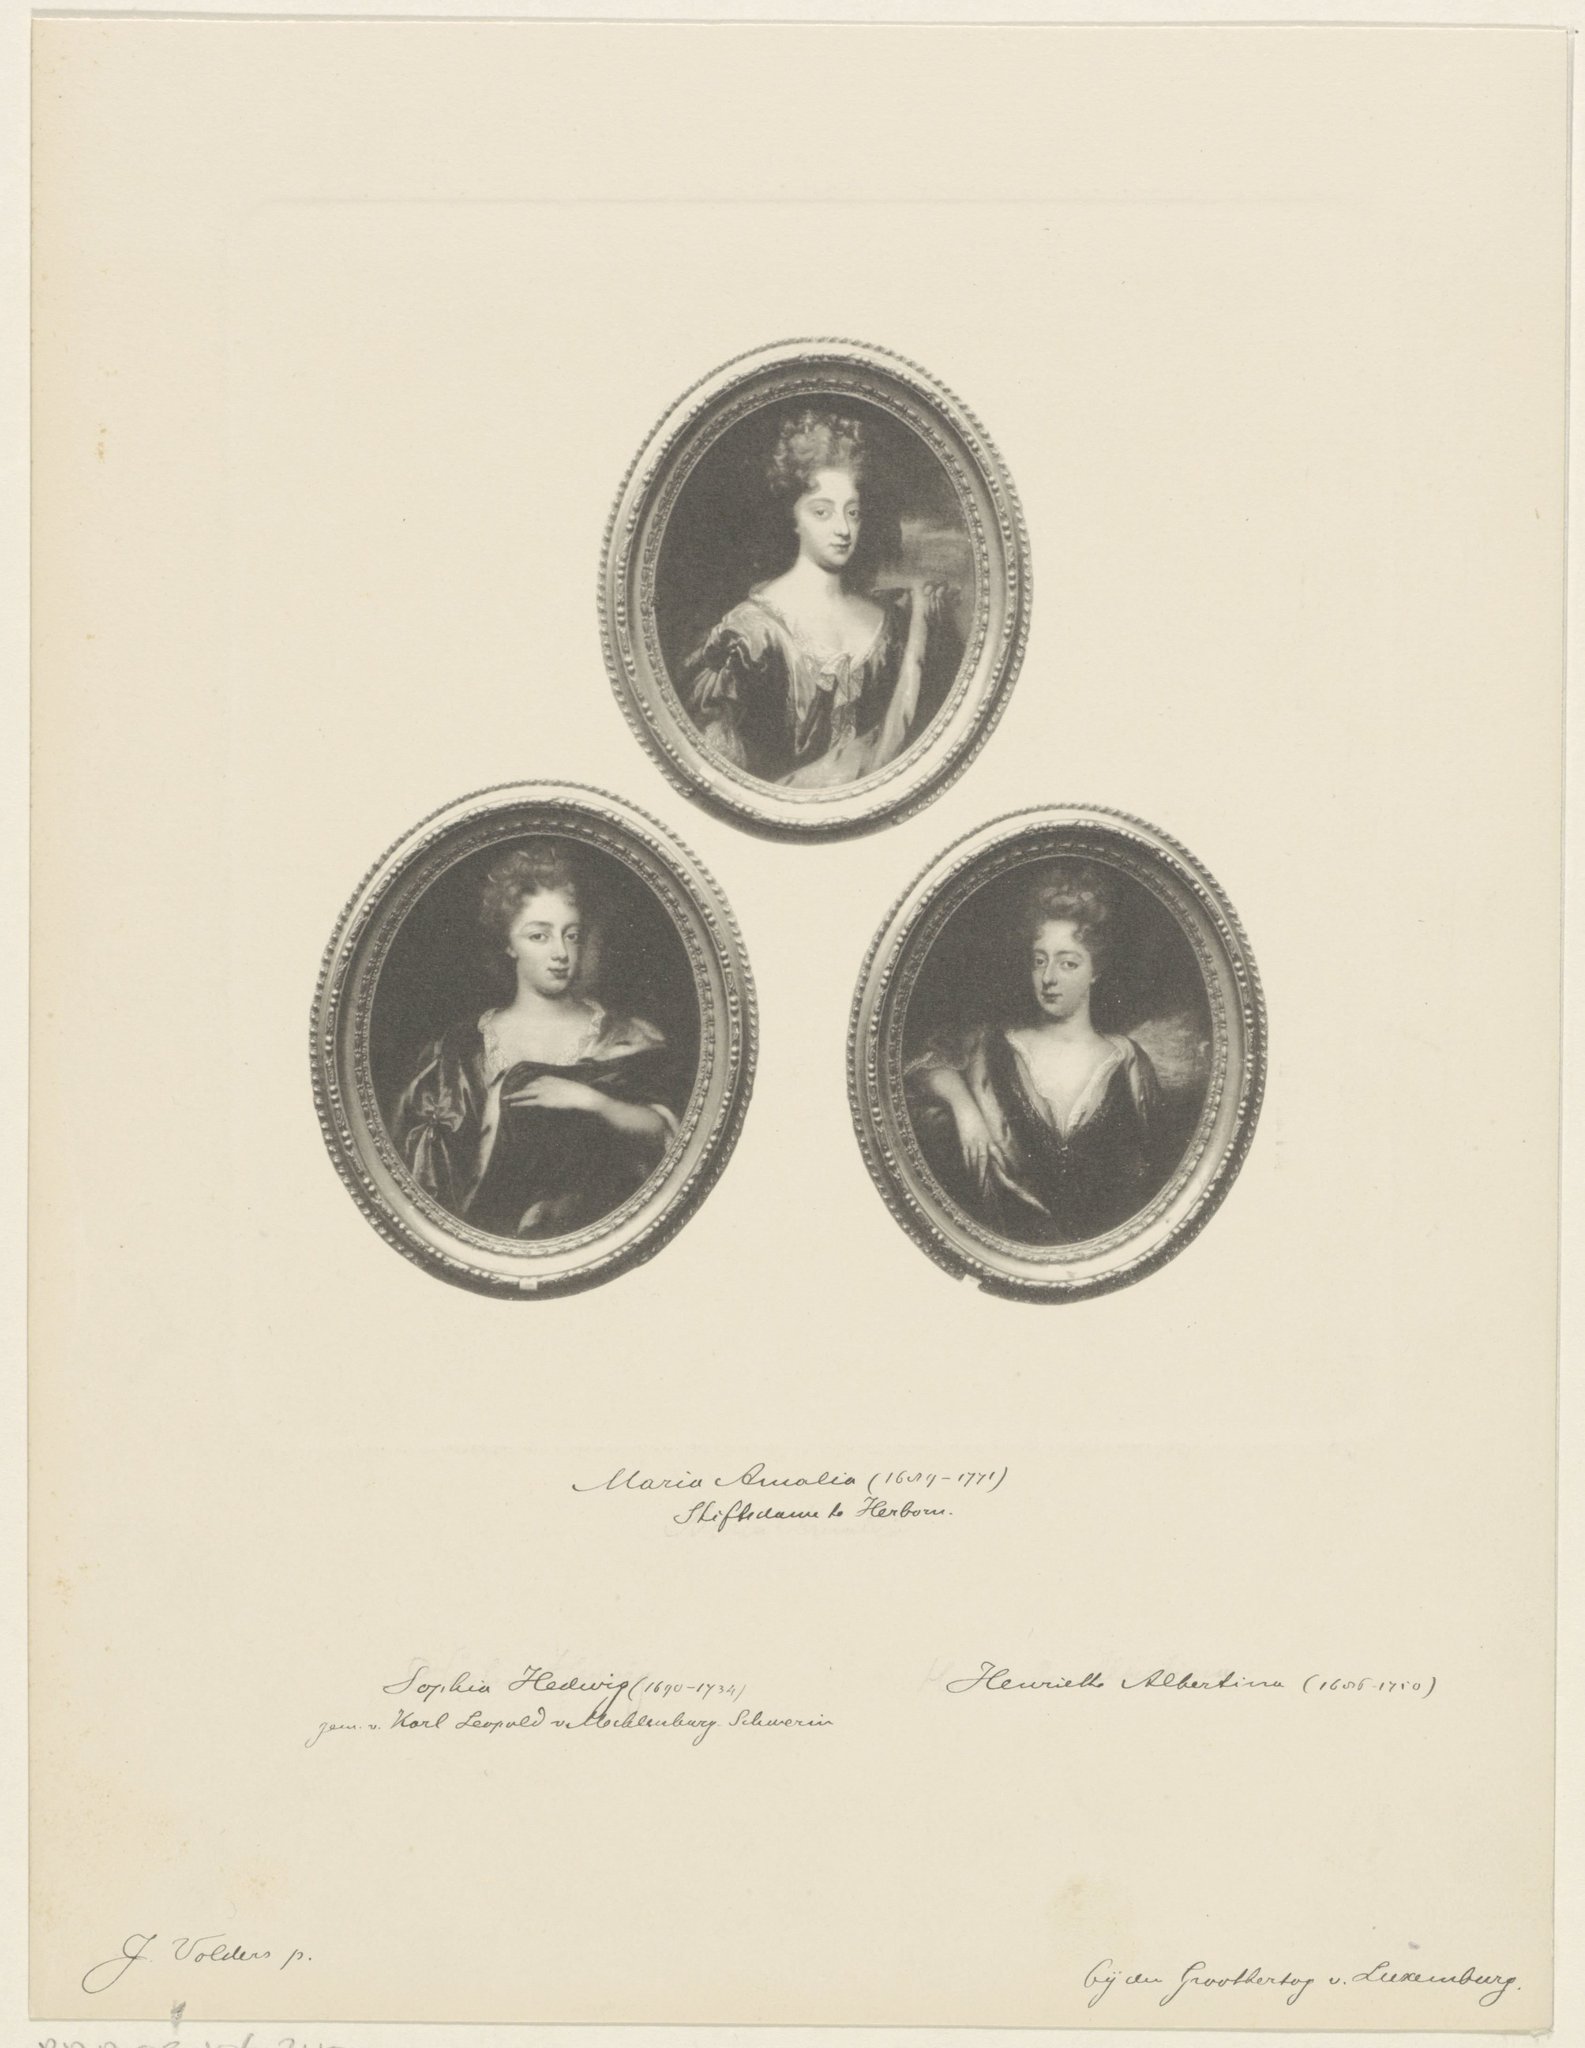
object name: photomechanical print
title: Portretten van Henriëtte Albertine, gravin van Nassau-Dietz, Maria Amalia, gravin van Nassau-Dietz, en Sophia Hedwig, gravin van Nassau-Dietz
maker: Anonymous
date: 1850-1949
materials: paper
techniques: photograph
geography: netherlands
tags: maria amalia gravin van nassau-dietz, sophia hedwig gravin van nassau-dietz, leeuwarden, oranienstein, schloss, henriëtte albertine gravin van nassau-dietz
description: De hier vermelde titel verwijst naar de hoogst verkregen titel van de geportretteerde, niet per se naar de titel die de geportretteerde op deze voorstelling draagt.